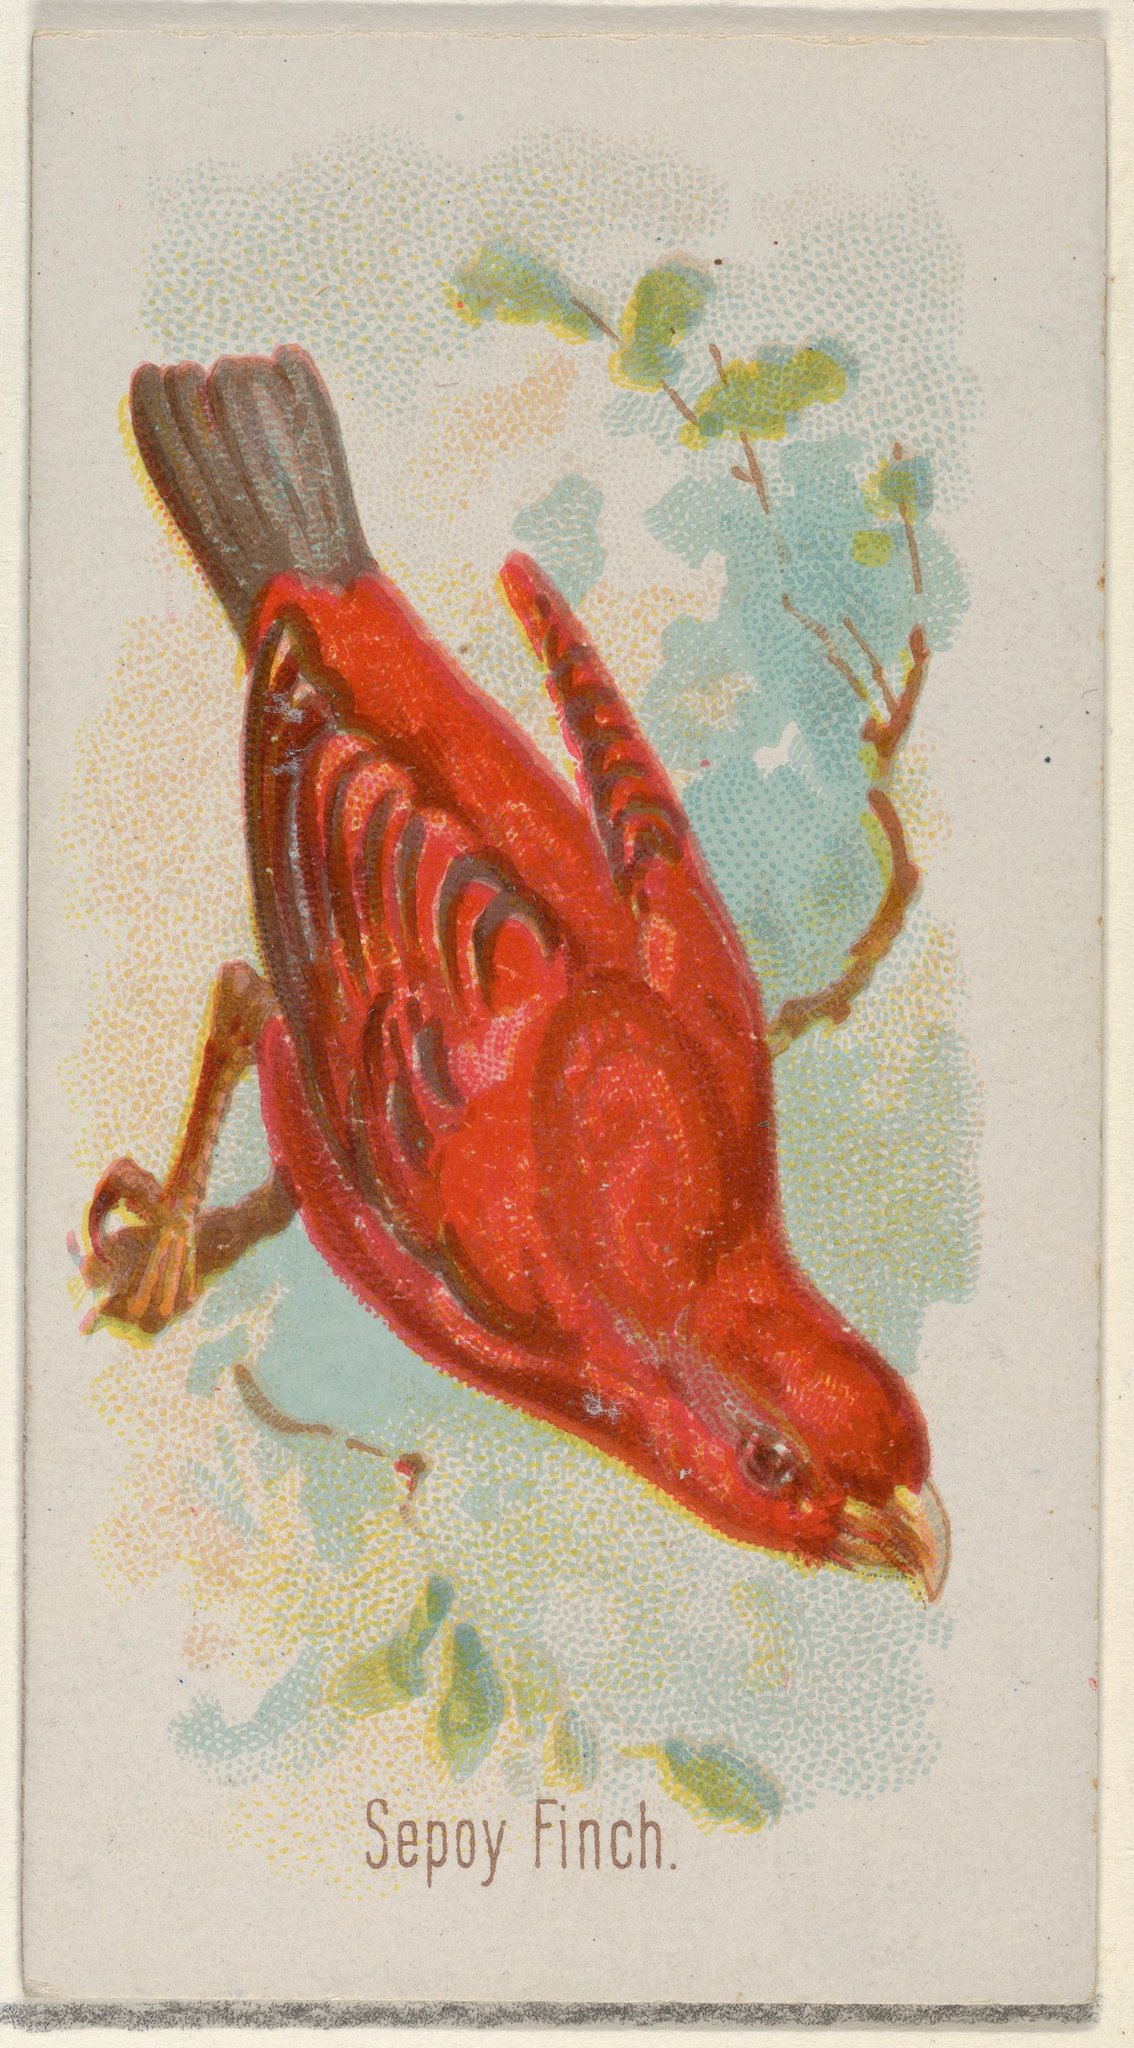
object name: print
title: Sepoy Finch, from the Song Birds of the World series (N23) for Allen & Ginter Cigarettes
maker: allen & ginter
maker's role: publisher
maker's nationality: american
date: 1890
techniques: color lithograph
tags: birds